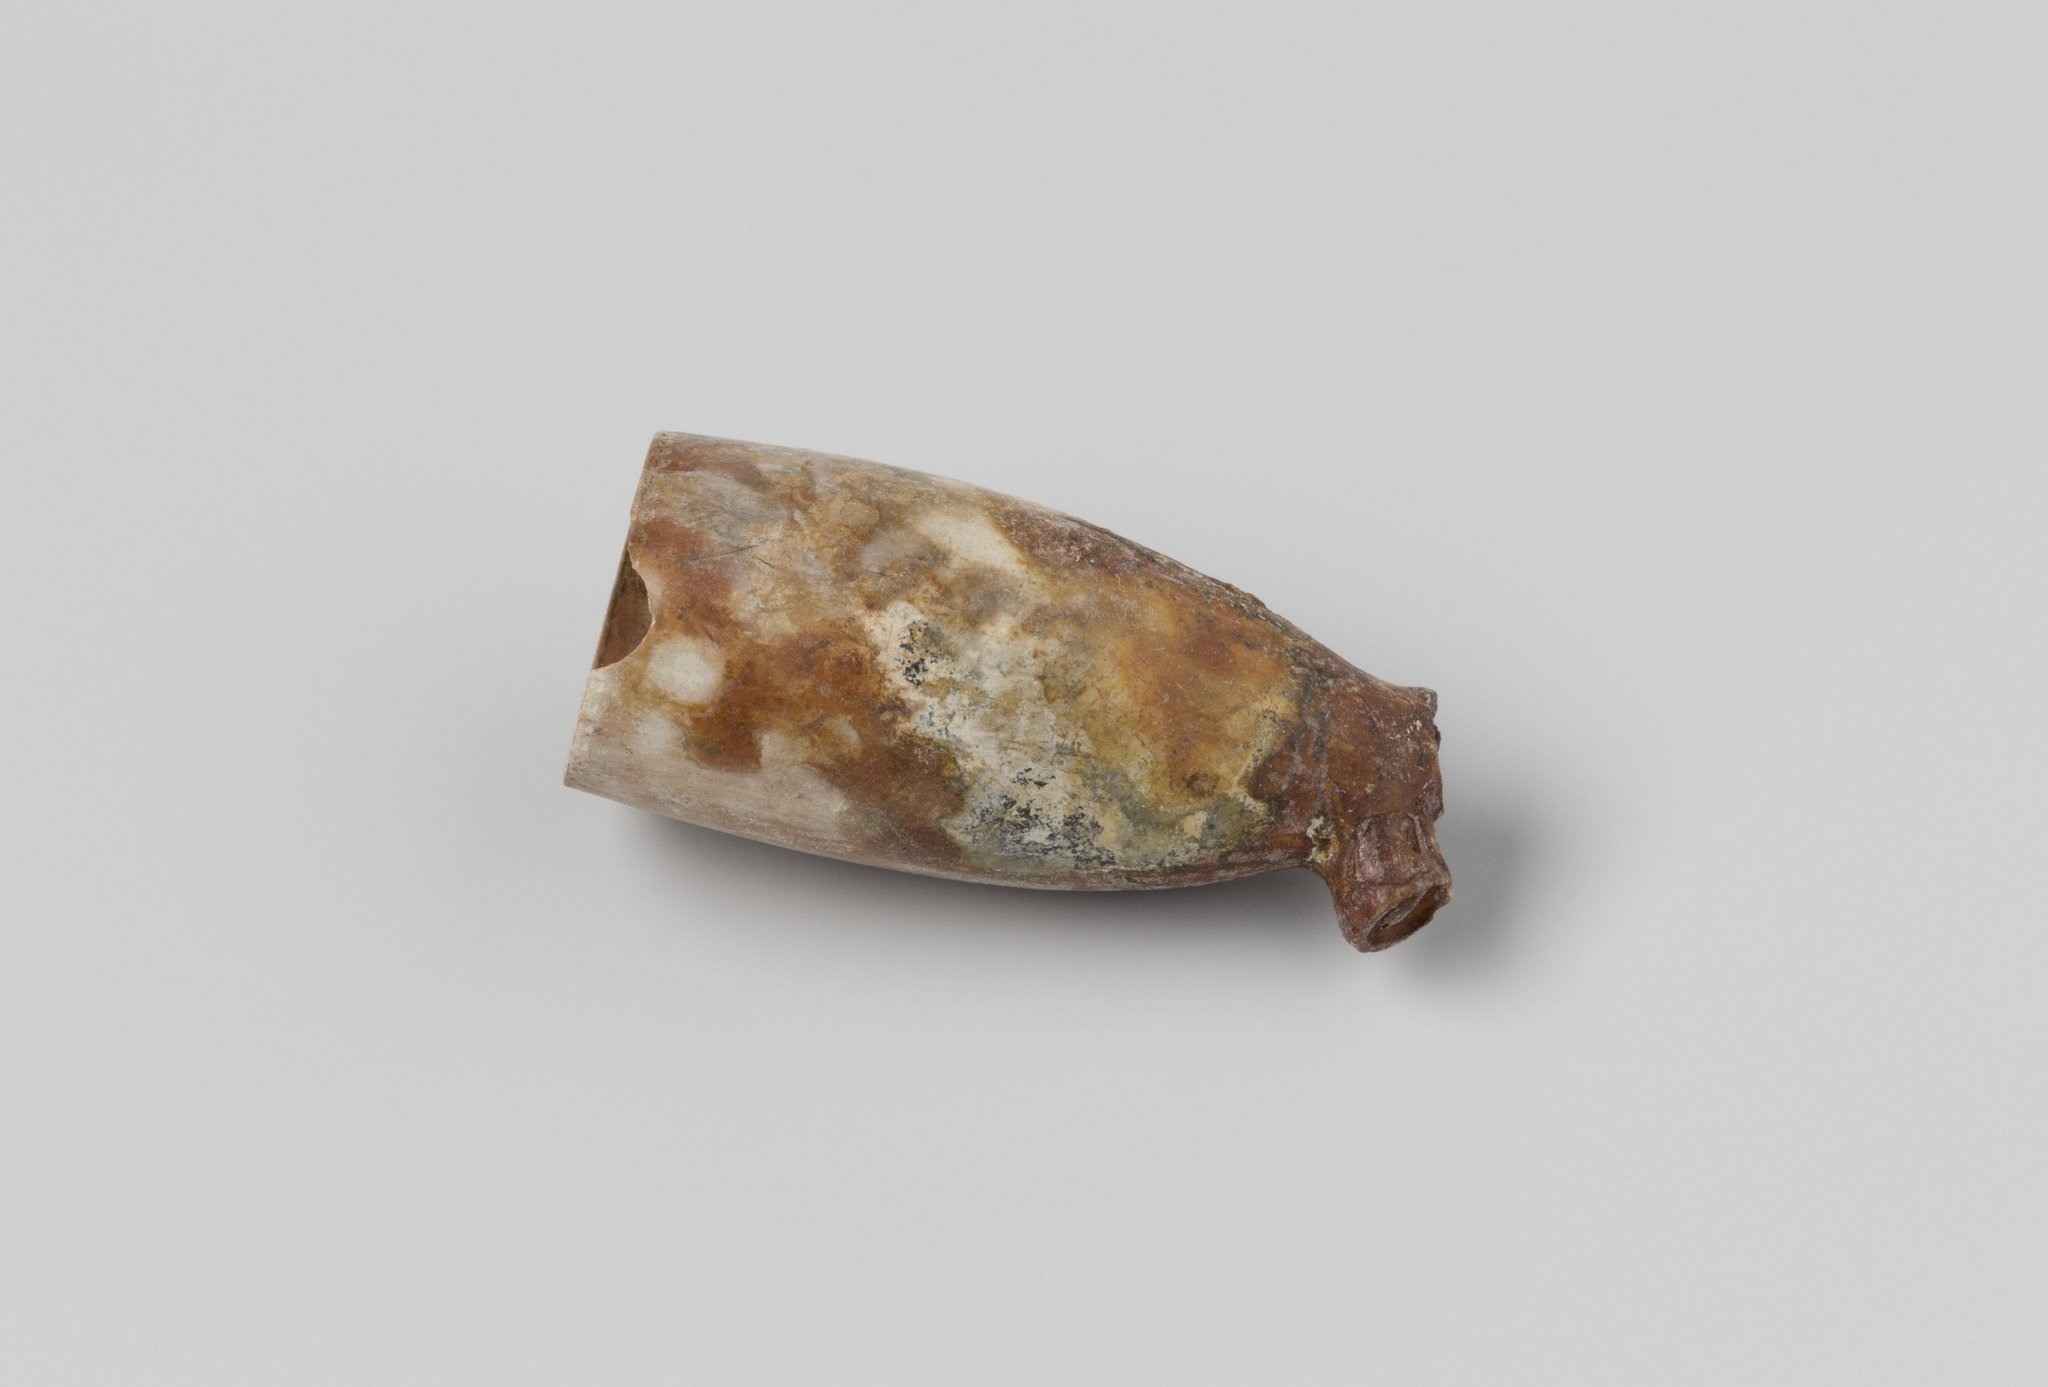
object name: pipe bowl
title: Pijpenkop uit het wrak van de Oost-Indiëvaarder Hollandia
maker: Anonymous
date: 1700-1743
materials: clay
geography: netherlands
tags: verenigde oostindische compagnie, hollandia (schip), annet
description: Pipe, bowl, heelmark: fish, flounder; 2hsm1,6.